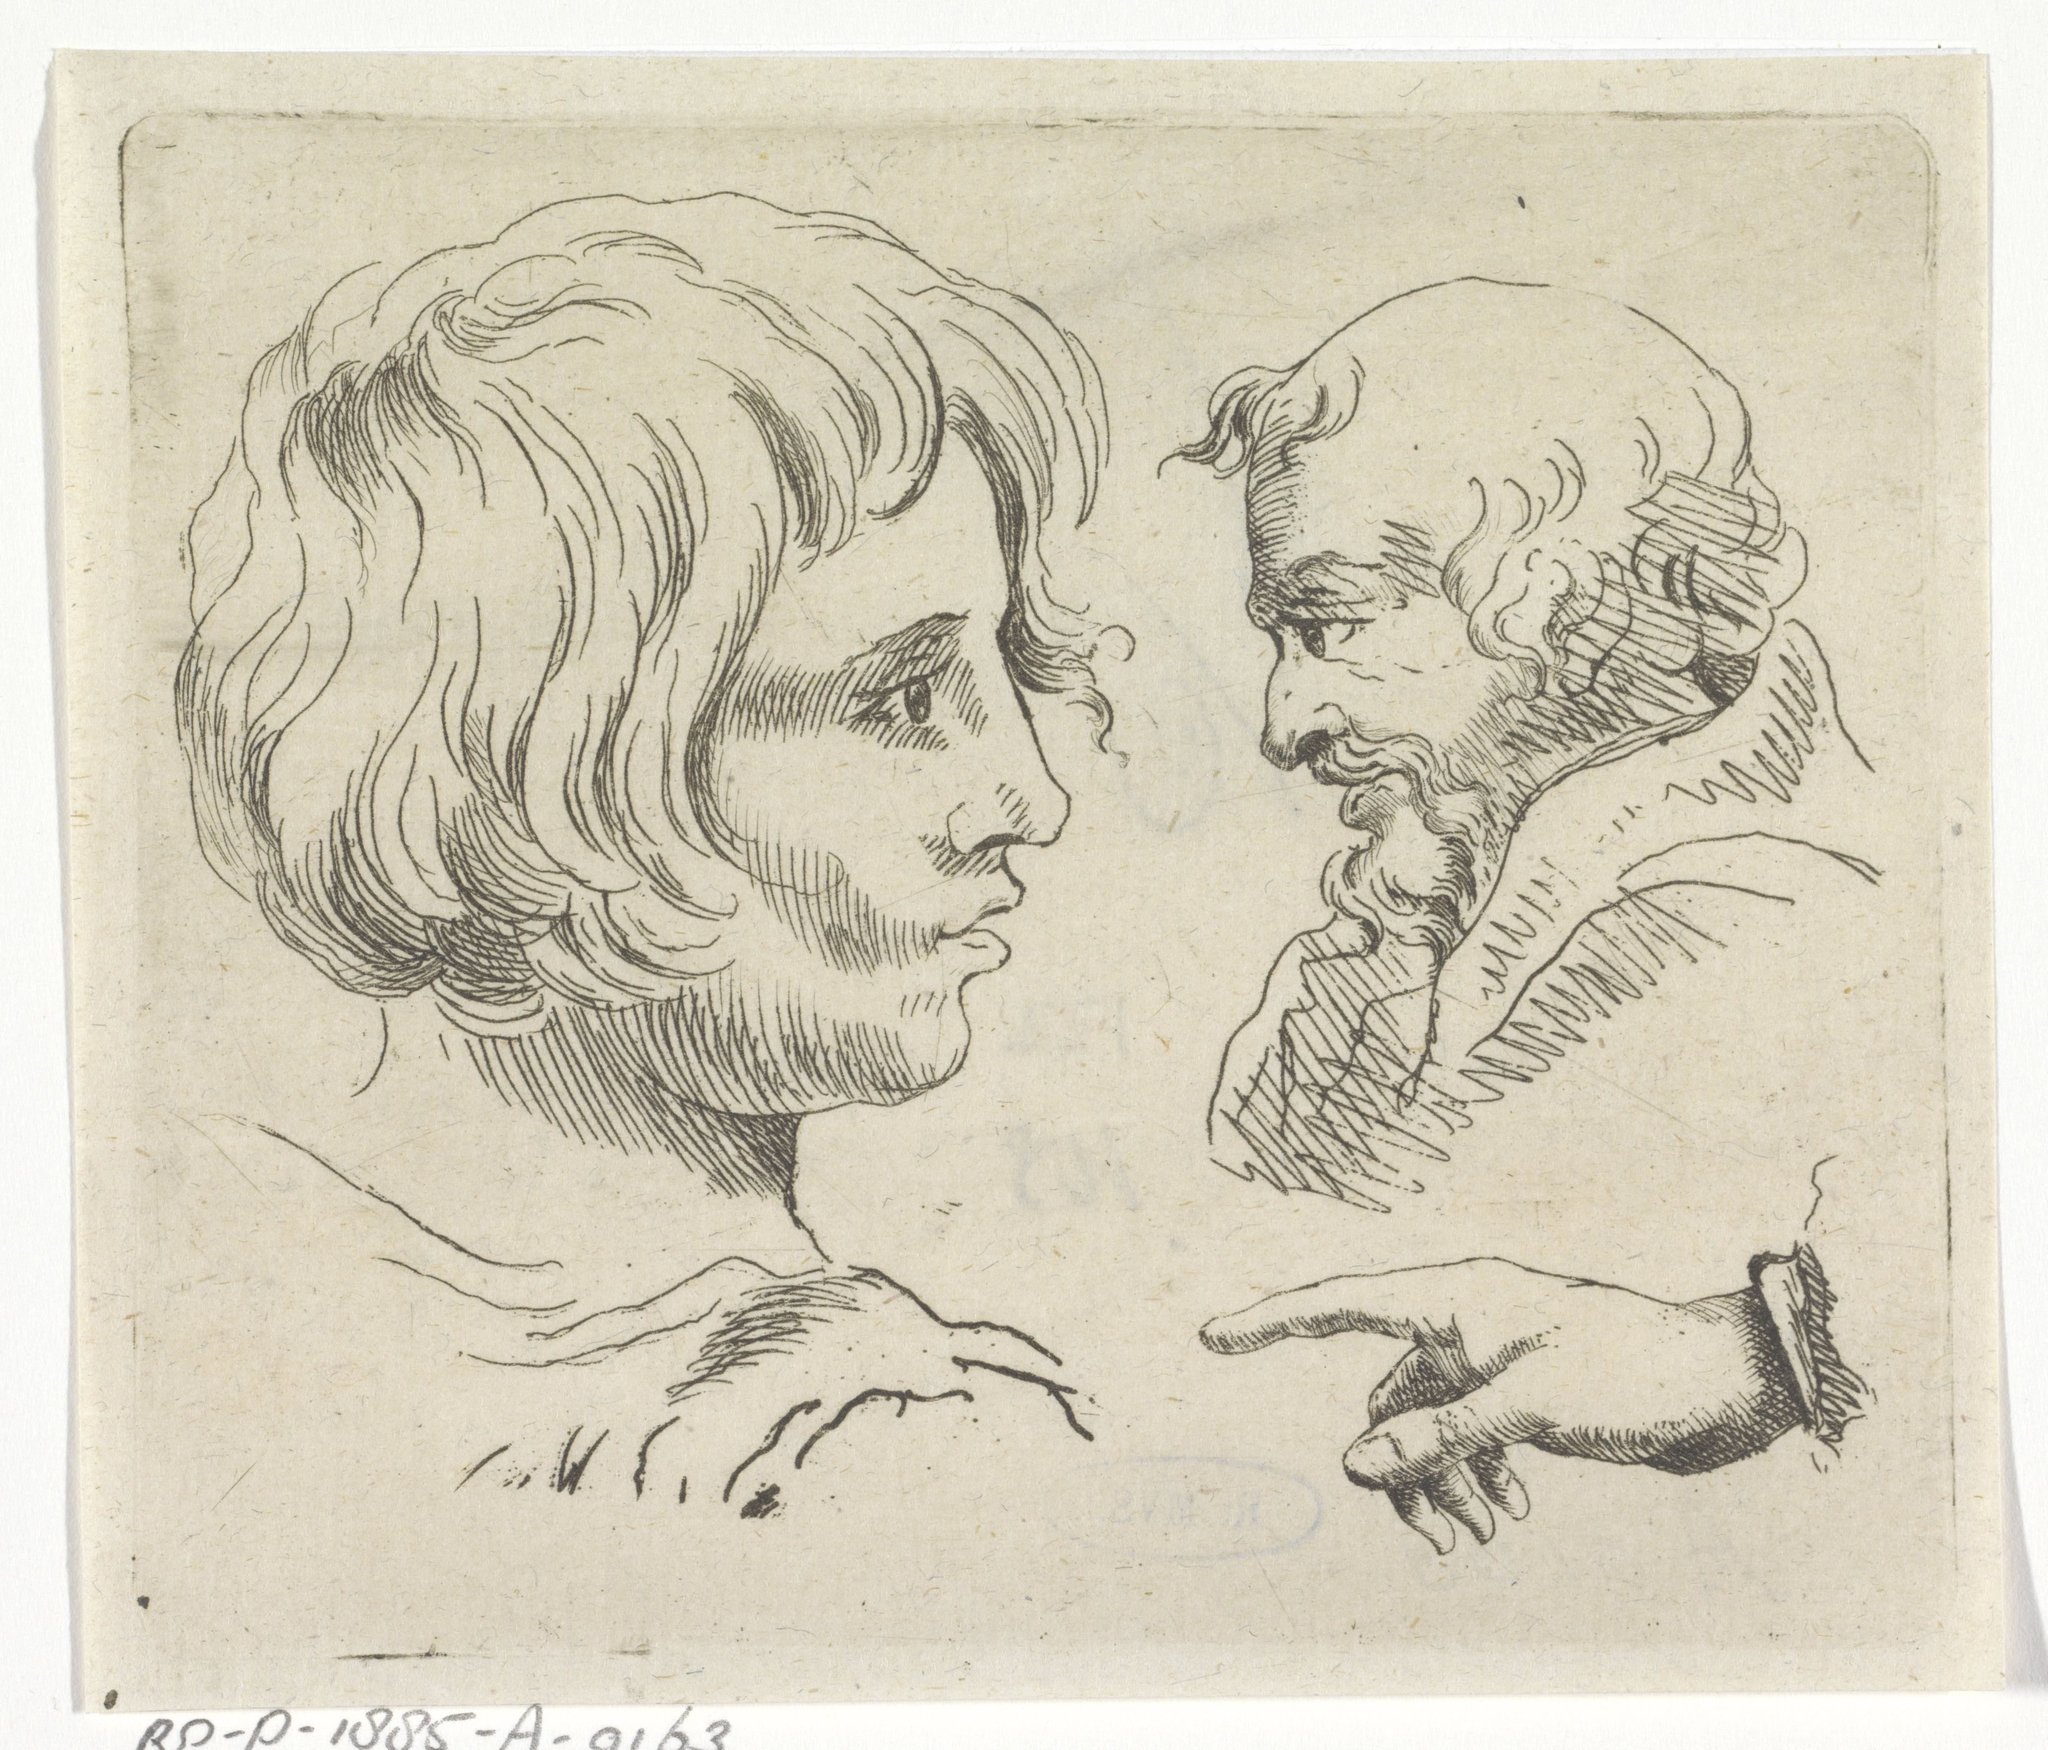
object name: print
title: Studieblad met een kindergezicht, het gezicht van een oude man en een wijzende hand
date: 1800-1885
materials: paper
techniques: etching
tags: child, old man, index finger forwards, pointing, indicating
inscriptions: collector's mark: Lugt 2228, collector's mark: Lugt 2610